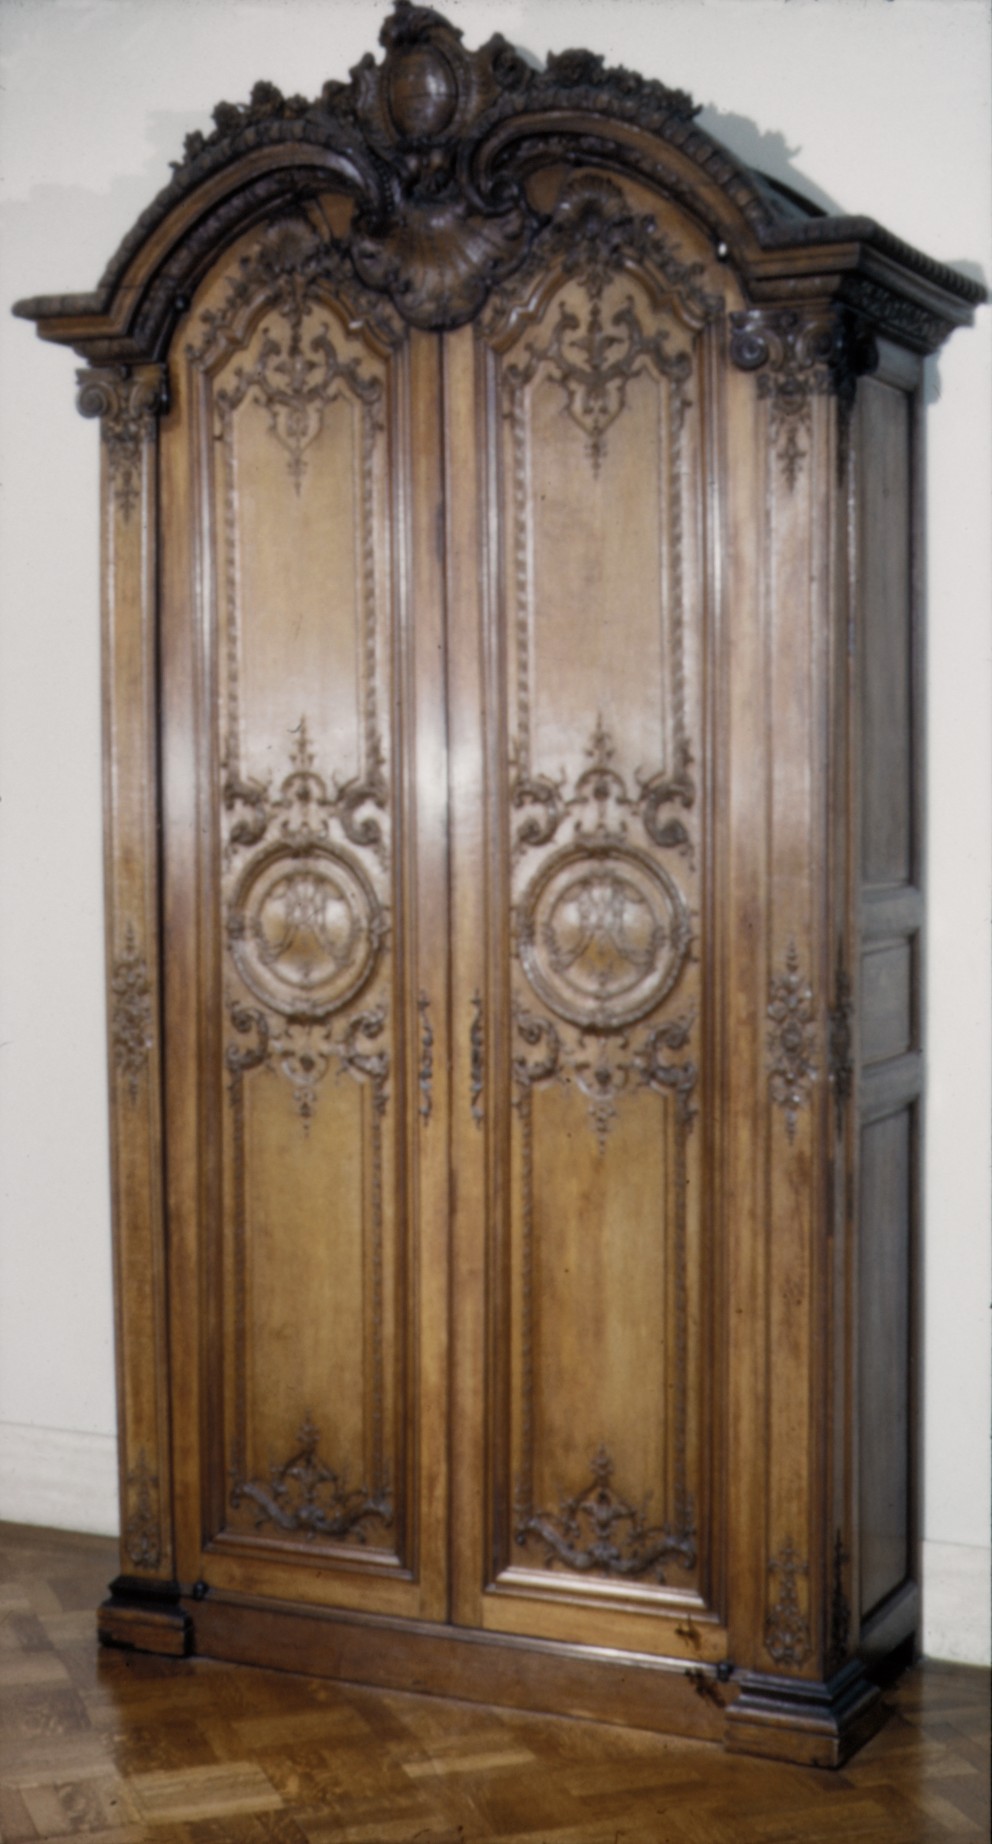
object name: armoire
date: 1710-1720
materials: wood